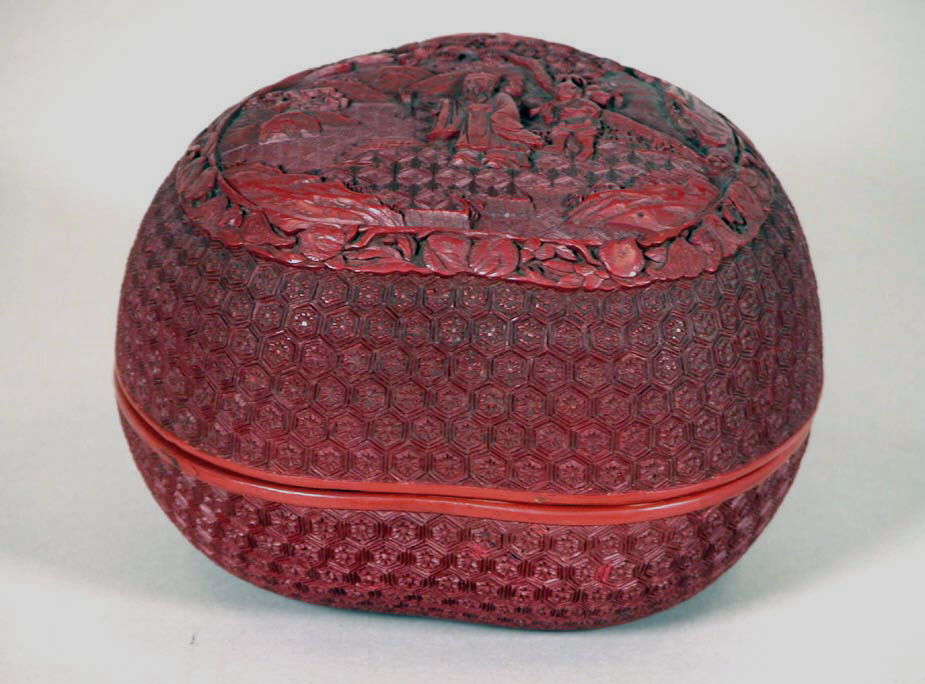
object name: box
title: Box in Peach Shape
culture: chinese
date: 1801-1833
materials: lacquer